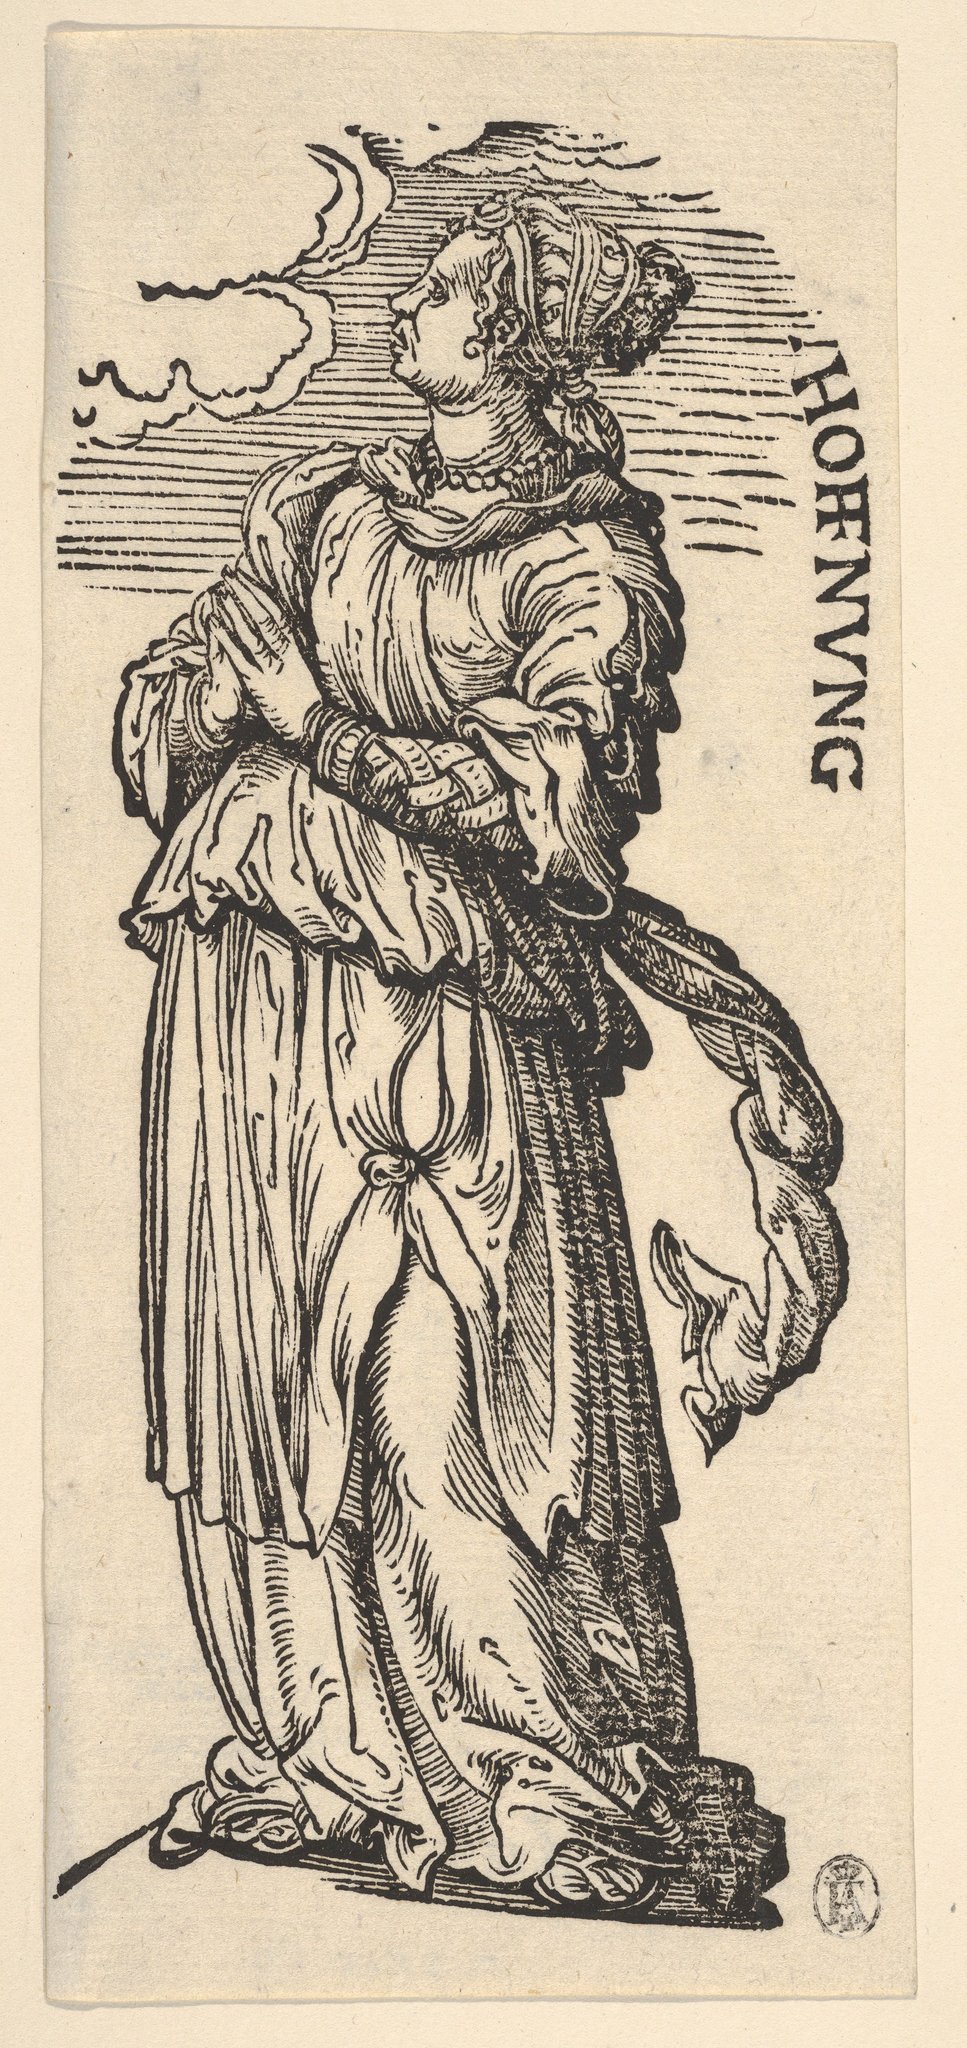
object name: print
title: Hope (Hoffnung), from "The Seven Virtues"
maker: hans burgkmair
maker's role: artist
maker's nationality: german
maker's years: 1473-1531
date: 1498-1531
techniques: woodcut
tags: profiles,women